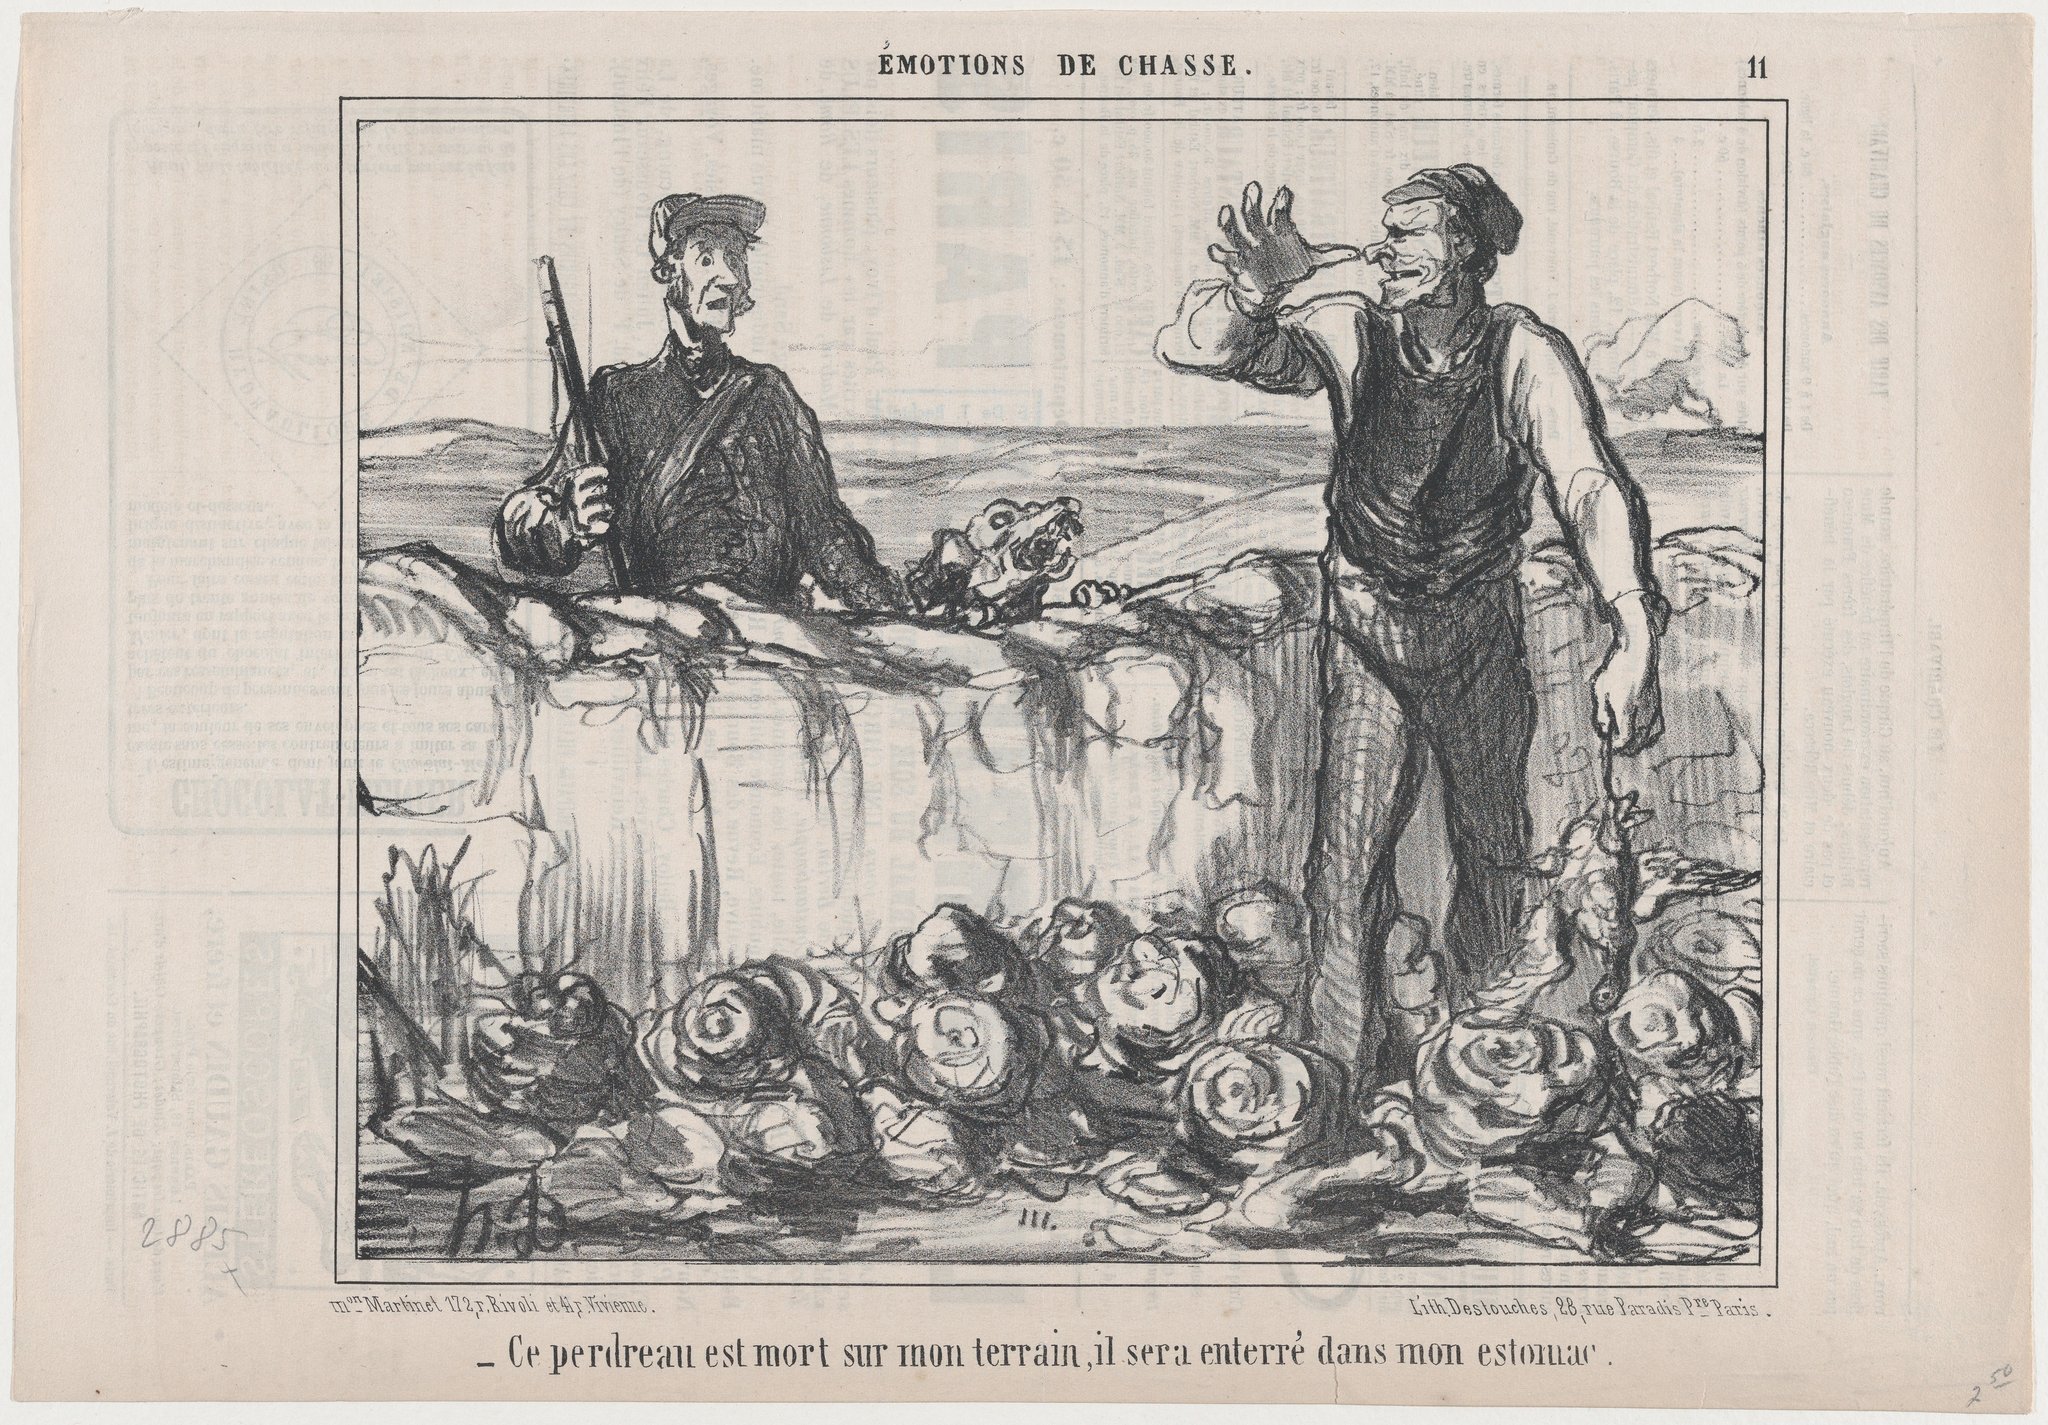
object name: print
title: Ce perdreau est mort sur mon terrain..., from "Émotions de Chasse"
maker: honoré daumier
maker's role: artist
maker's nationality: french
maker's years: 1808-1879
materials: paper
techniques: lithograph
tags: men,dogs